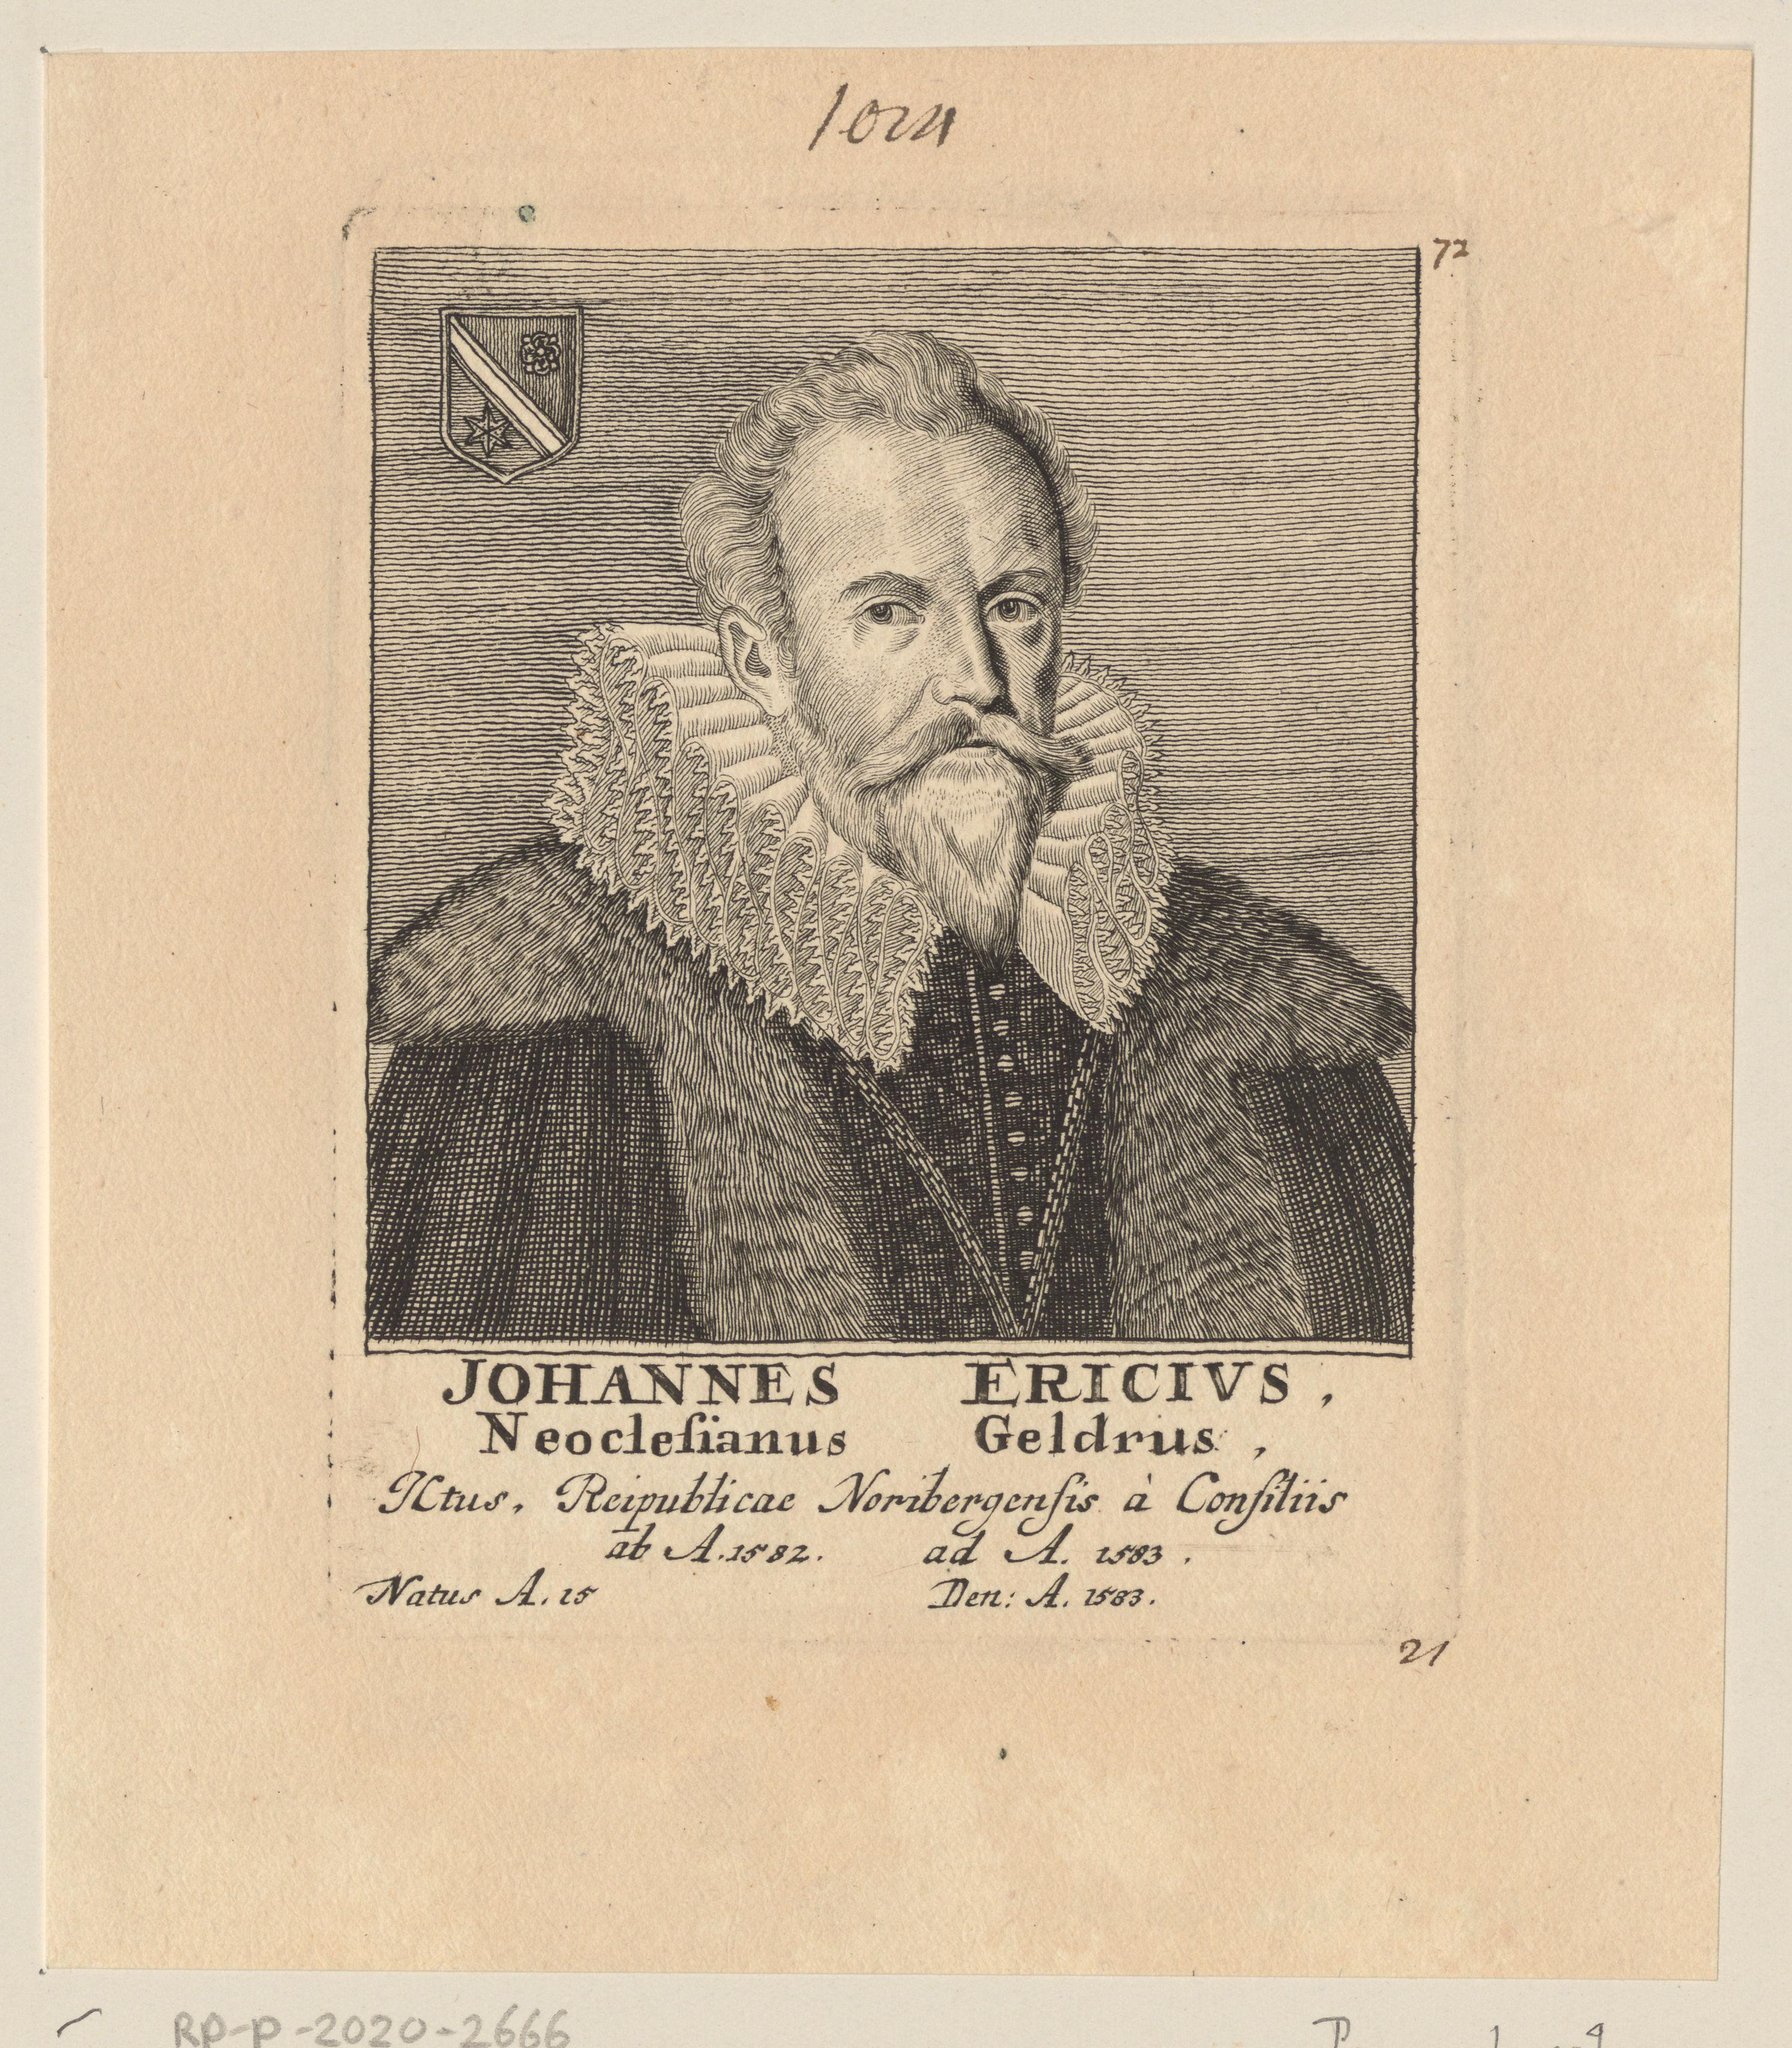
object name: print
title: Portret van Johann Ericius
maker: georg wolfgang knorr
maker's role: print maker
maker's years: 1705-1761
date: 1723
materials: paper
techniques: engraving, etching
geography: germany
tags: historical persons, armorial bearing, heraldry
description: Prent waarschijnlijk uit: Rothscholtz, Friedrich. Icones consiliariorum de illustri republica Noribergensi (...). Neurenberg en Altdorf: erven Johann Daniel Tauber, 1723.